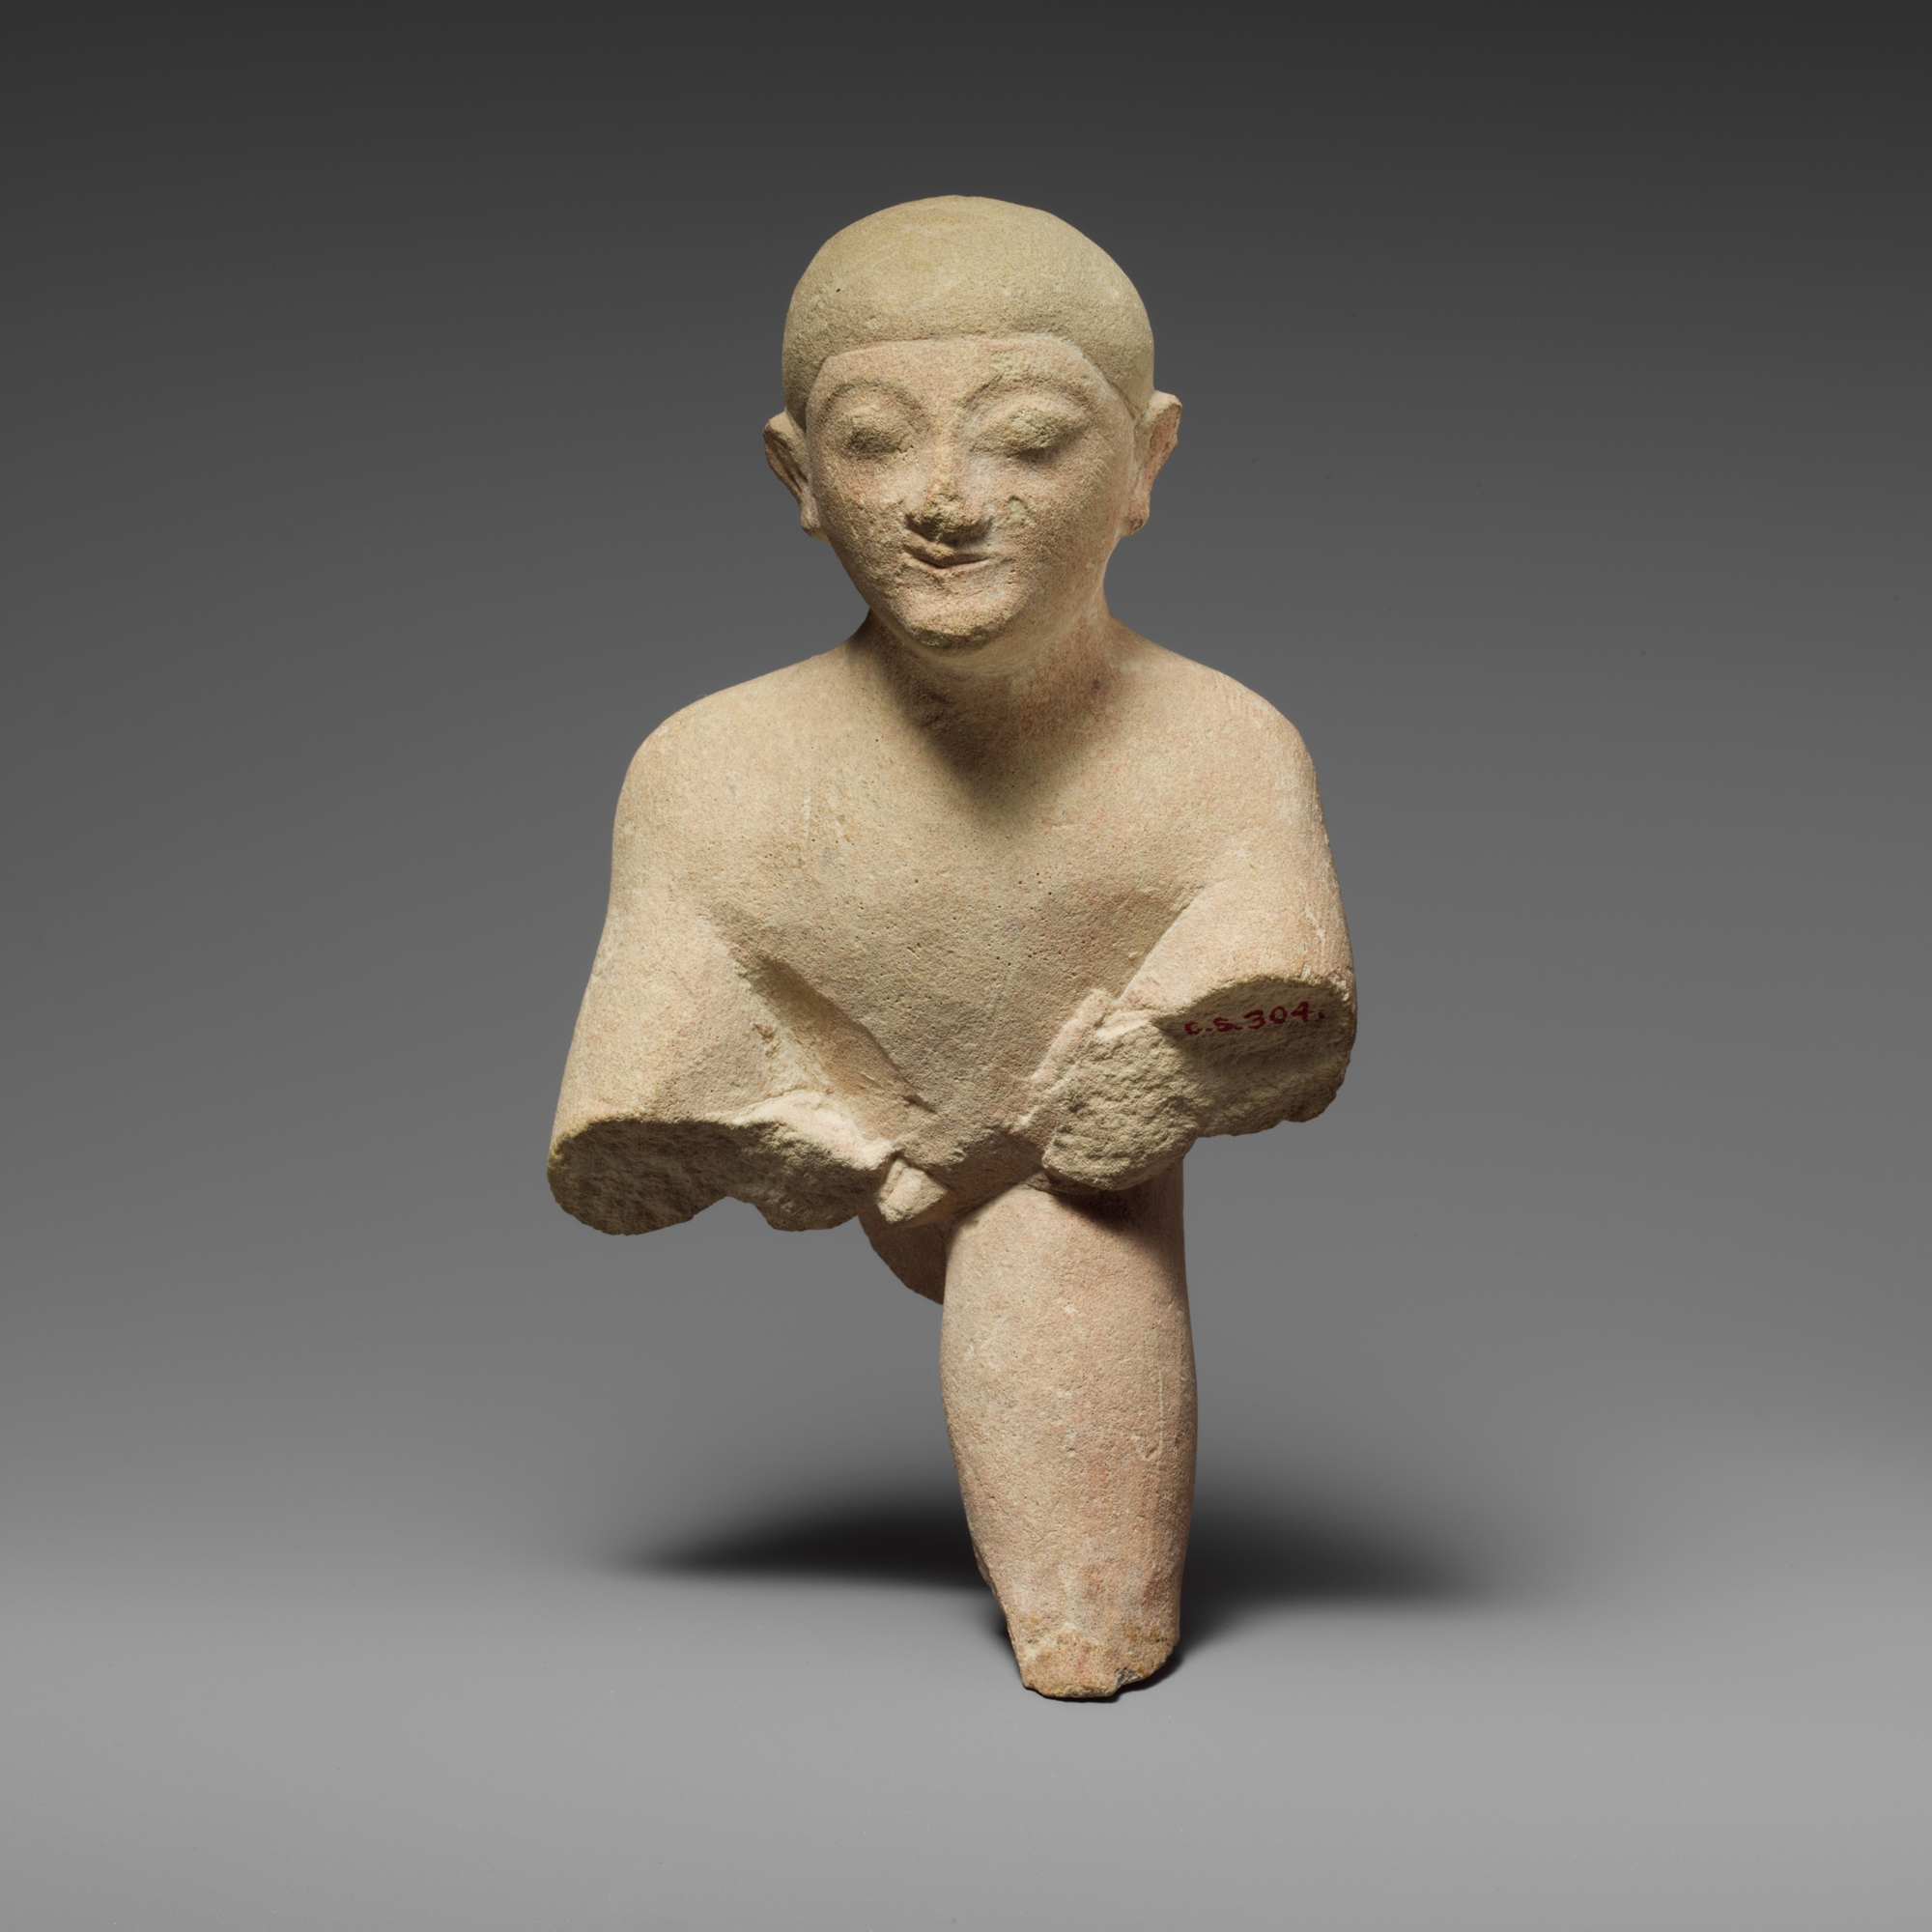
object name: statuette of a dwarf in egyptian style, wrestling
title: Fragment of a limestone group of wrestlers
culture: cypriot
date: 600-501 BCE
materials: limestone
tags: men